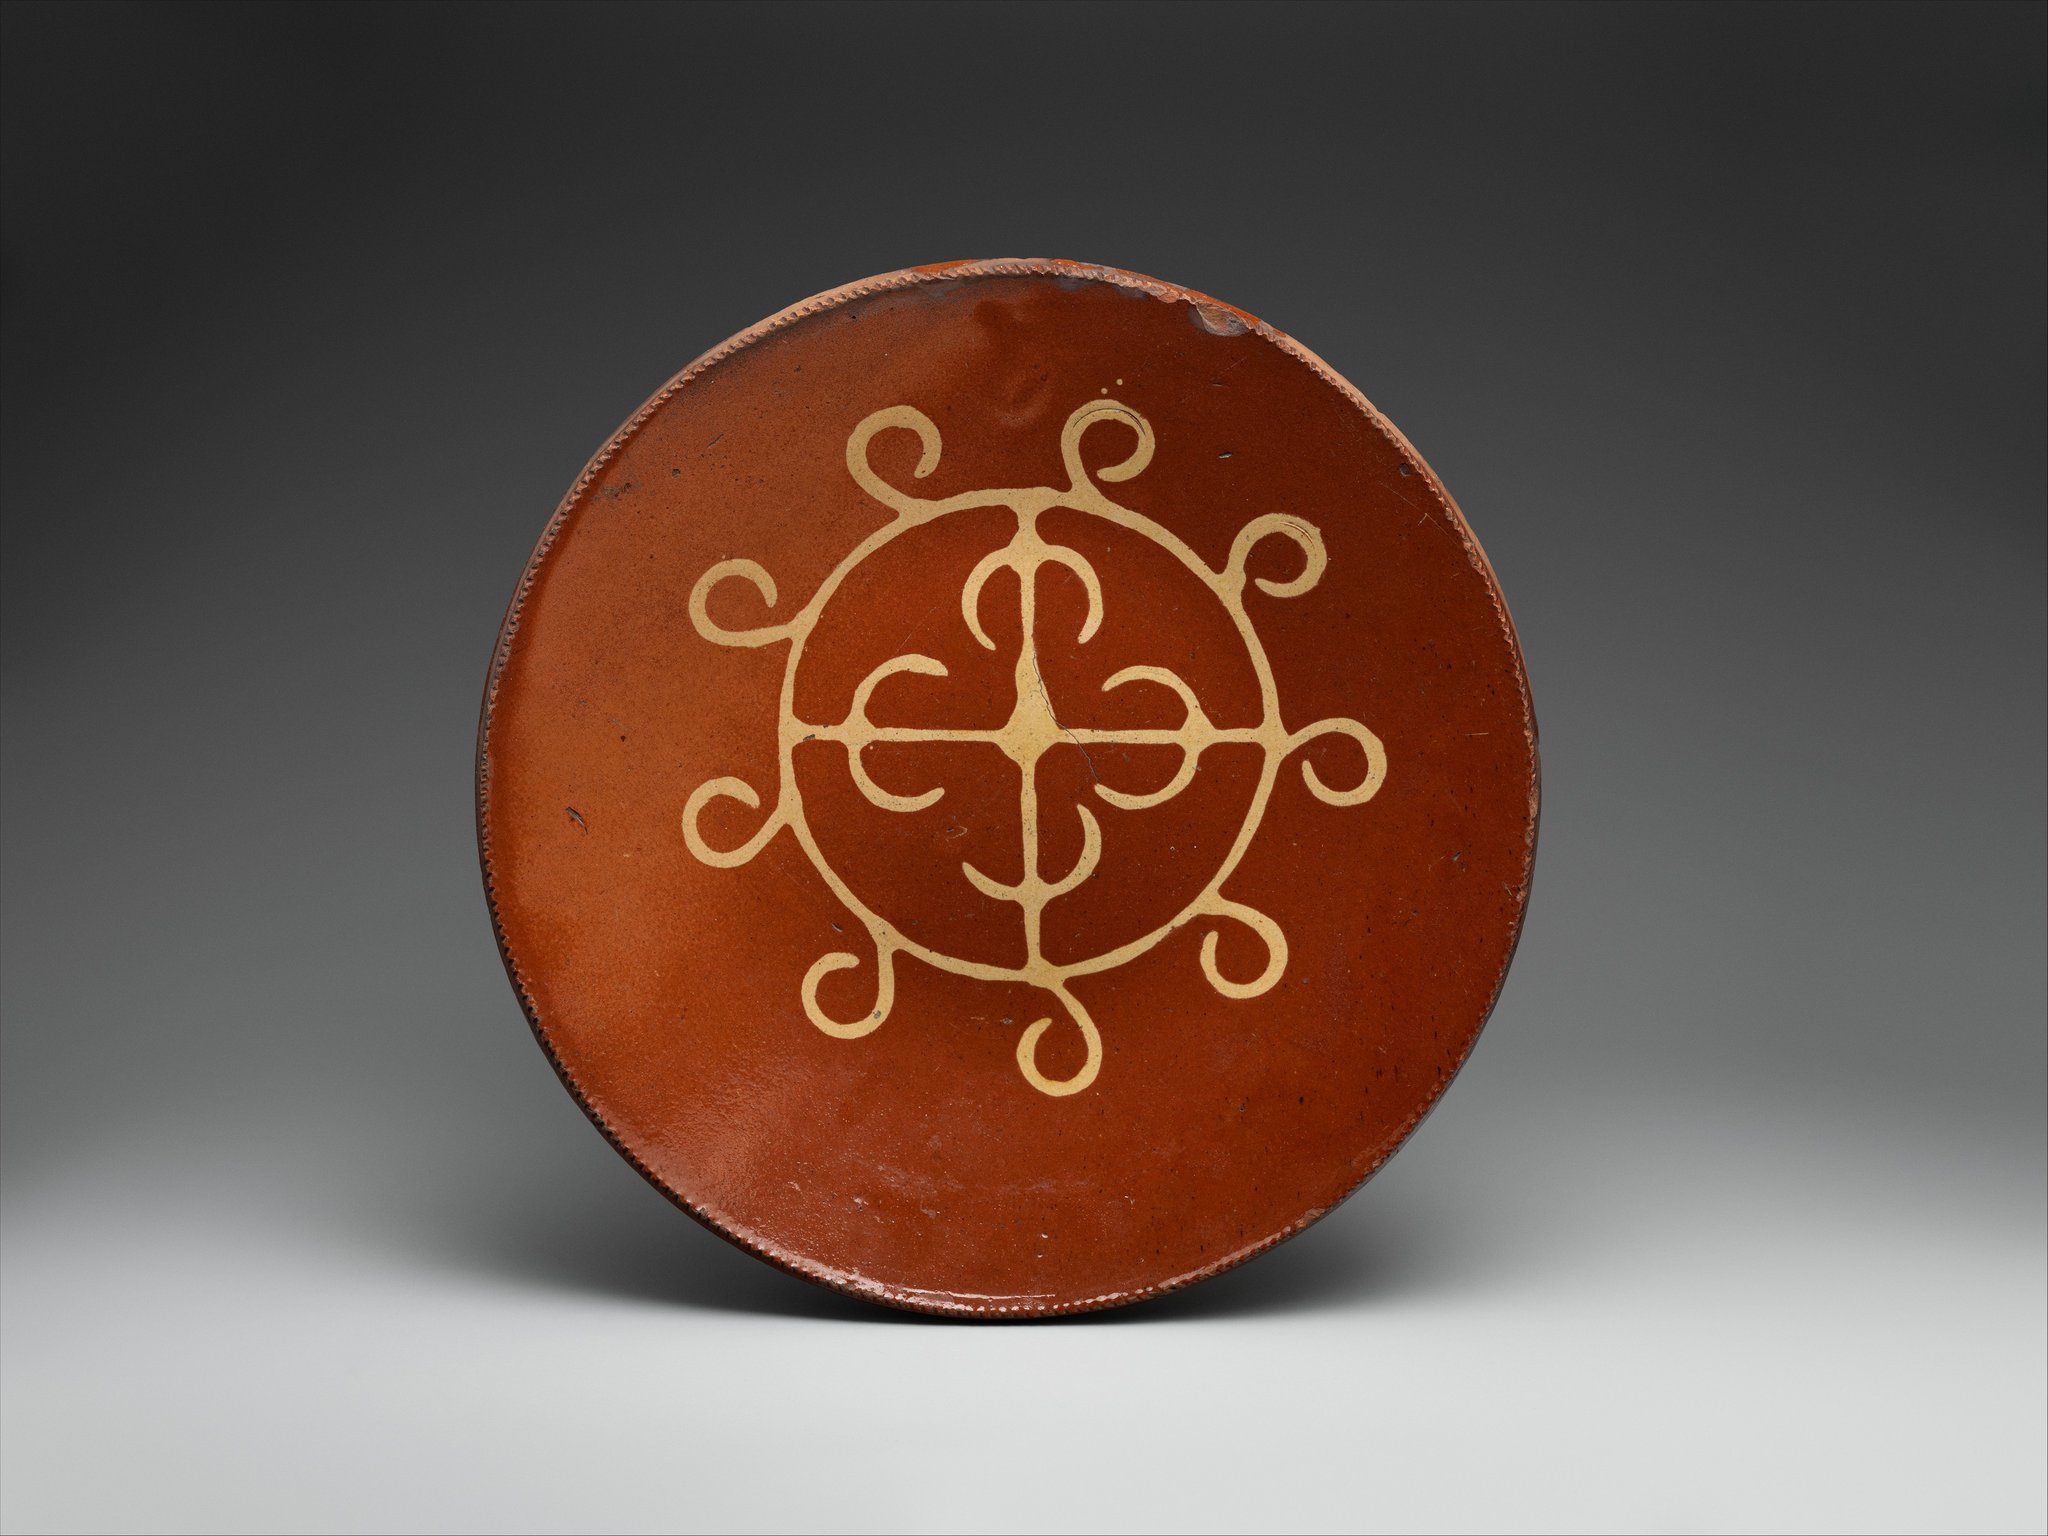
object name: charger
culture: american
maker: Anonymous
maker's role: artist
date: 1840-1885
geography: united states